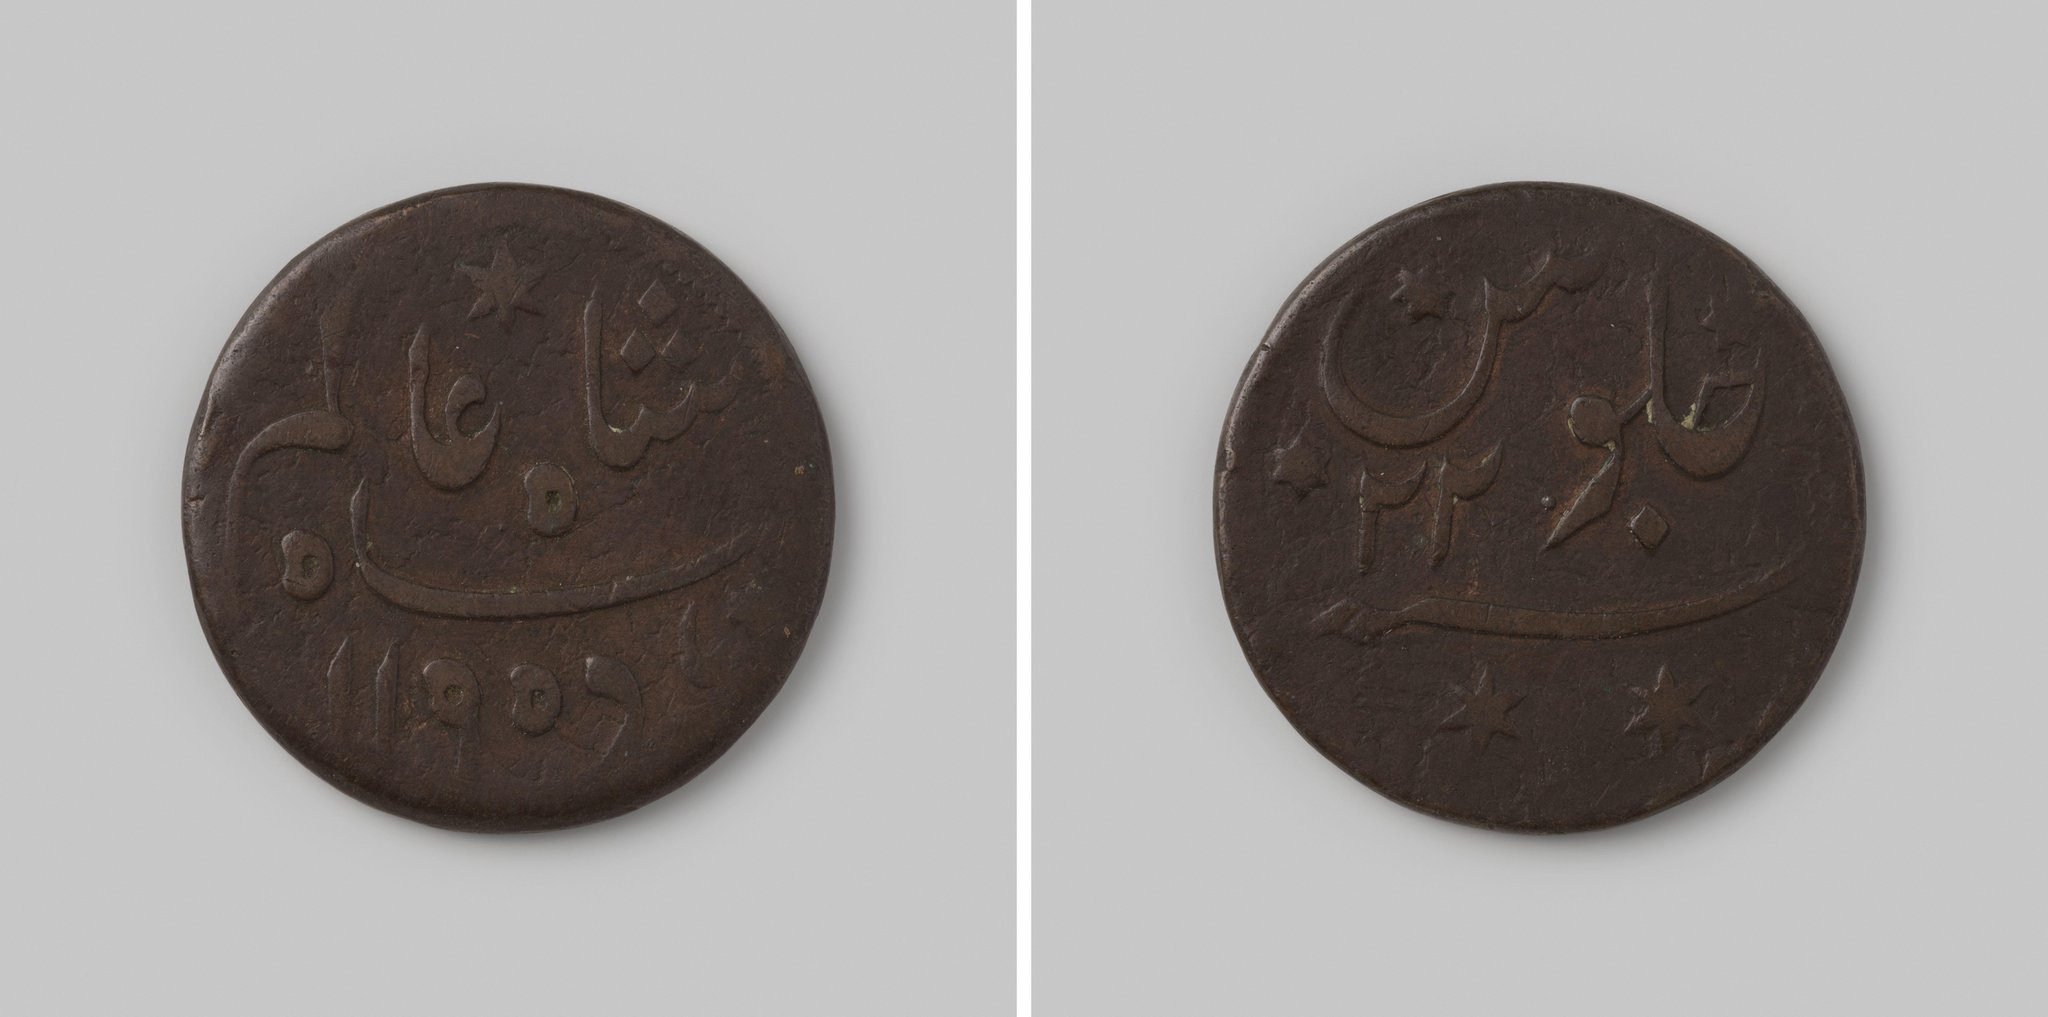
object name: coin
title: ½ anna uit Bengalen in India van de Engelse Oostindische Compagnie (EIC) op naam van Sjah Alam I, 1195 [=1780] en met regeringsjaar 22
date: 1780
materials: copper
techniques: striking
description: Koperen munt. Voorzijde: in Arabische lettertekens in twee regels opschrift. Onderaan jaartal:1195 [=1780]. Keerzijde: in Arabische lettertekens in twee regels opschrift met aanduiding van het regeringsjaar: 22. Gladde rand.